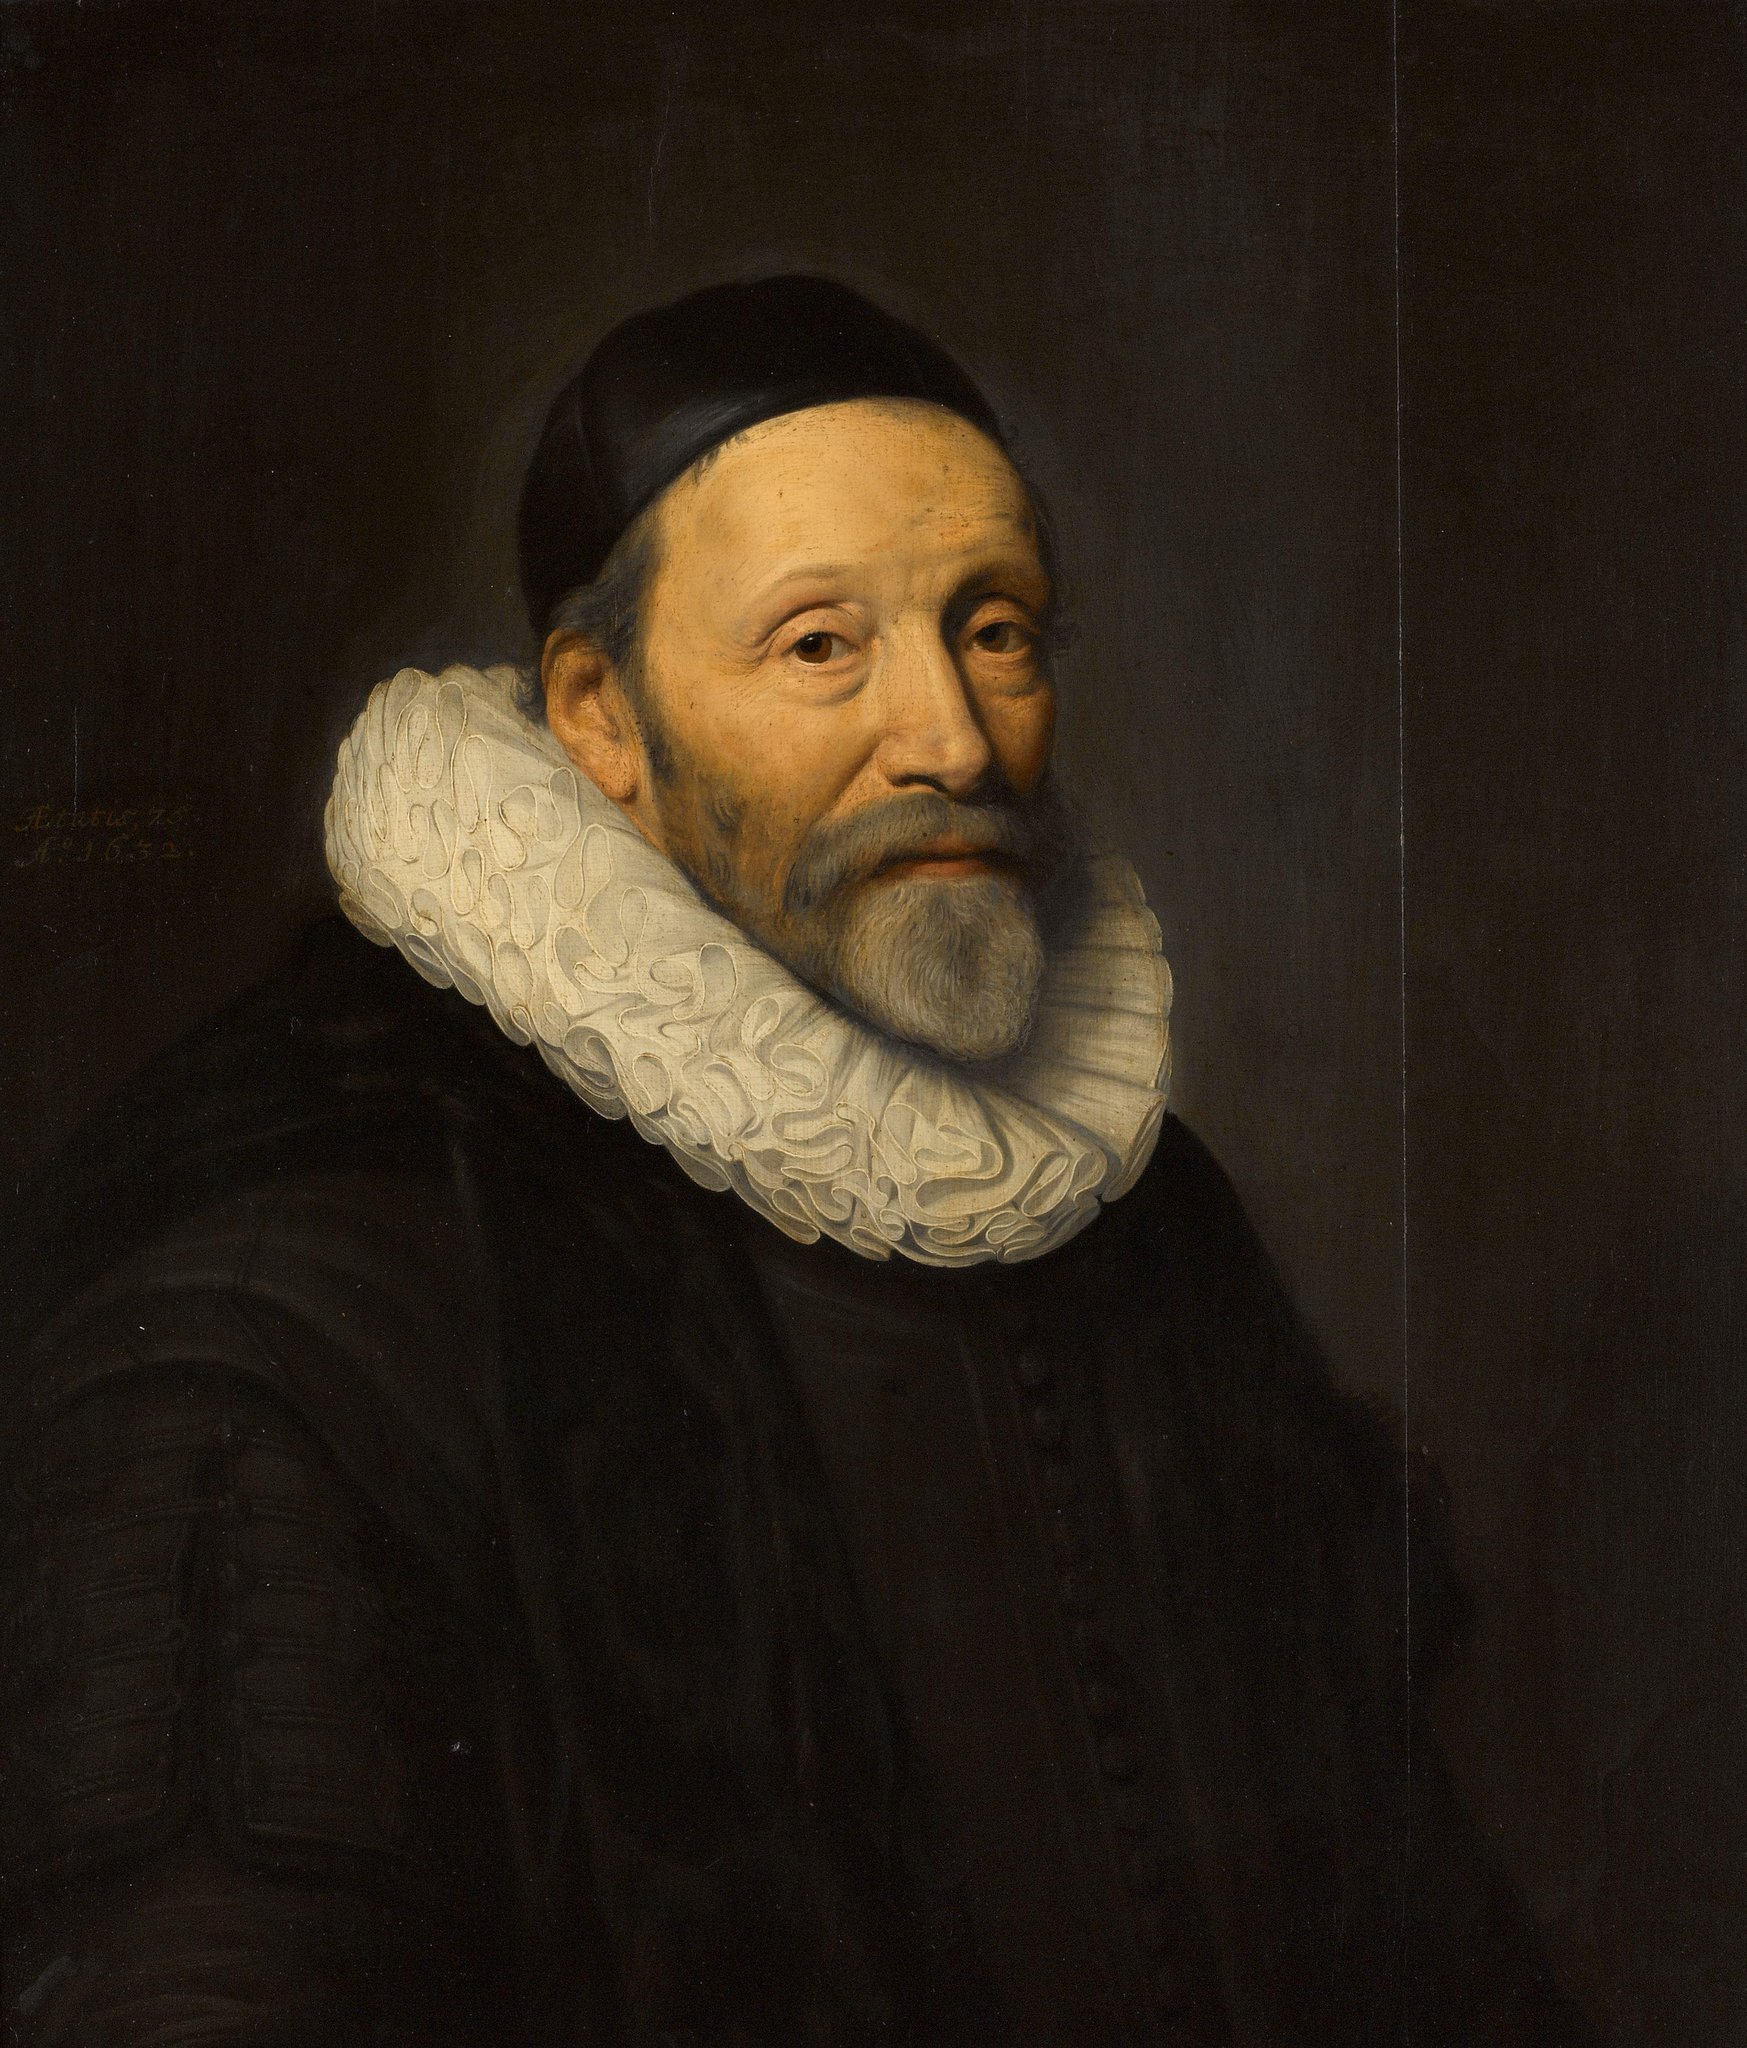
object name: painting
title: Portrait of Johannes Wtenbogaert (1557-1644)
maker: michiel jansz van mierevelt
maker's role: draughtsman, painter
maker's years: 1567-1641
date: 1632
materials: oil, panel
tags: utrecht, the hague, historical persons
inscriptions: inscription and date, centre left: ‘Ætatis 75. / Aº 1632.’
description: Johannes Uytenbogaert, by M.J. van Miereveld, 1632. Johannes Uytenbogaert (1557-1644) played a major part in the ecclesiastical and political life of the young Republic. In the late16th century he was appointed chaplain to the court of Prince Maurice. During the truce with Spain, however, the Stadholder and the minister found themselves on opposite sides.Uytenbogaert was one of the leaders of a critical movement within the Reformed Church - the Remonstrants - who came into conflict with Maurice and the more orthodox Calvinists. Uytenbogaert fell from grace and fled abroad. He eventually returned, after Maurice's death.